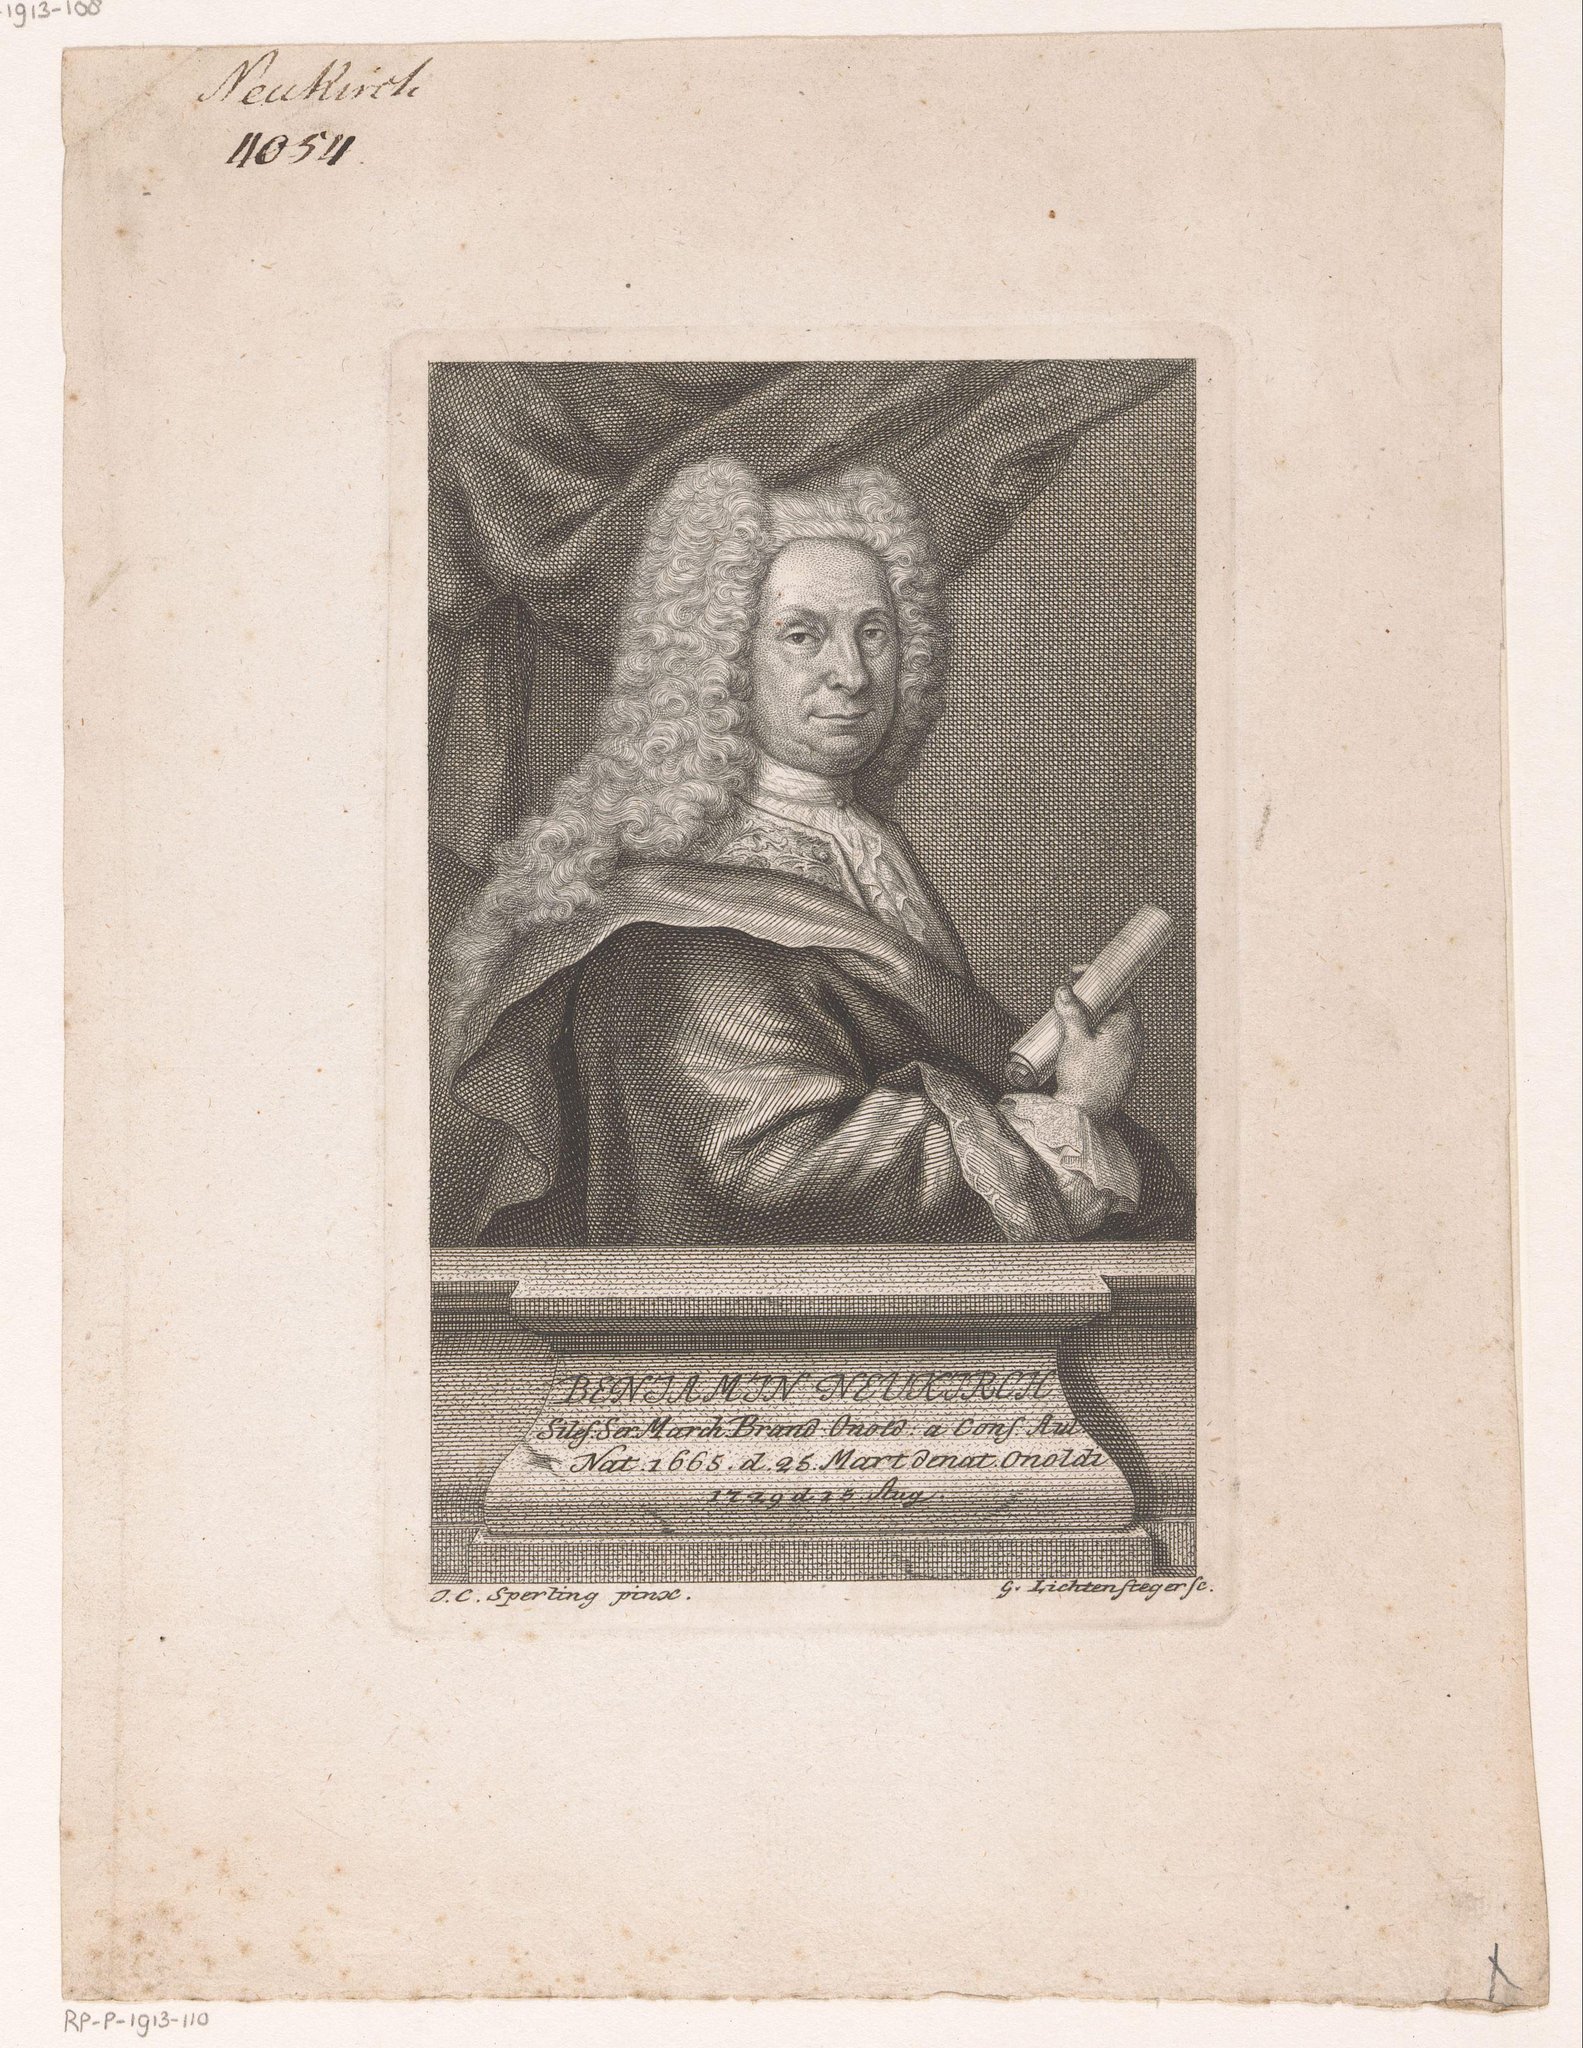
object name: print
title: Portret van Benjamin Neukirch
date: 1710-1781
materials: paper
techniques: engraving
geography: nuremberg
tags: historical persons, portrait of a writer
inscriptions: inscription, collector's mark: Lugt 2228